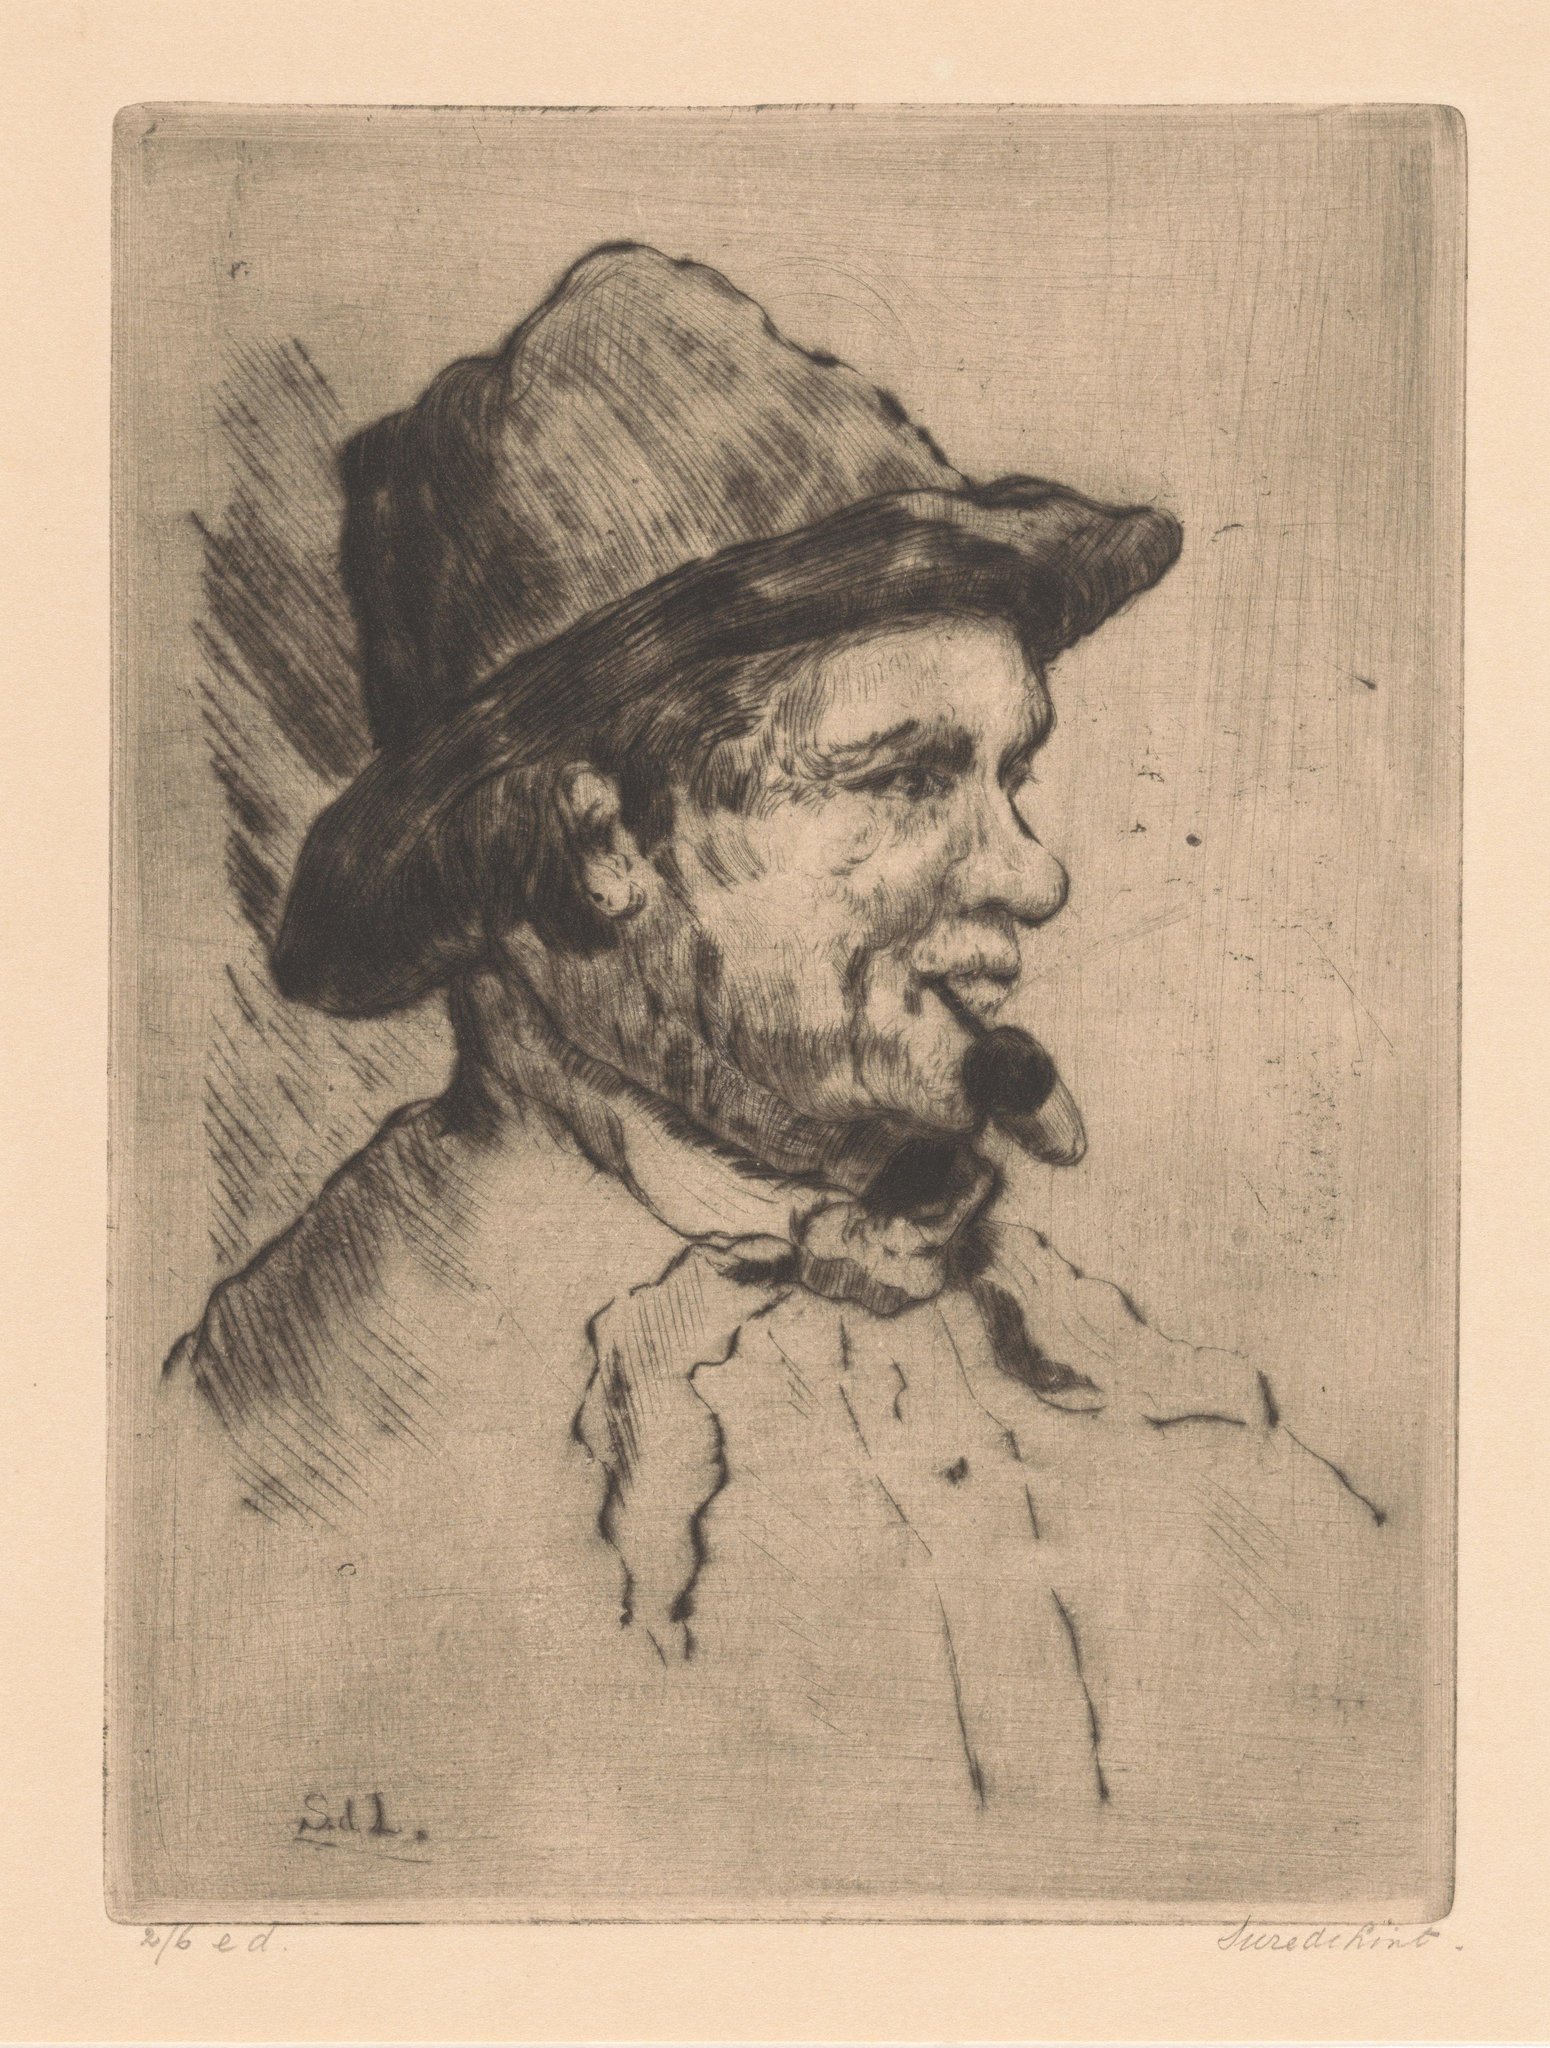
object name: print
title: Portret van een onbekende man met hoed en pijp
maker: suze de lint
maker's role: print maker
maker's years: 1878-1953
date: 1888-1931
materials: paper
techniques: drypoint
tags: adult man, pipe ~ tobacco, head-gear: hat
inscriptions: collector's mark: Lugt 2228